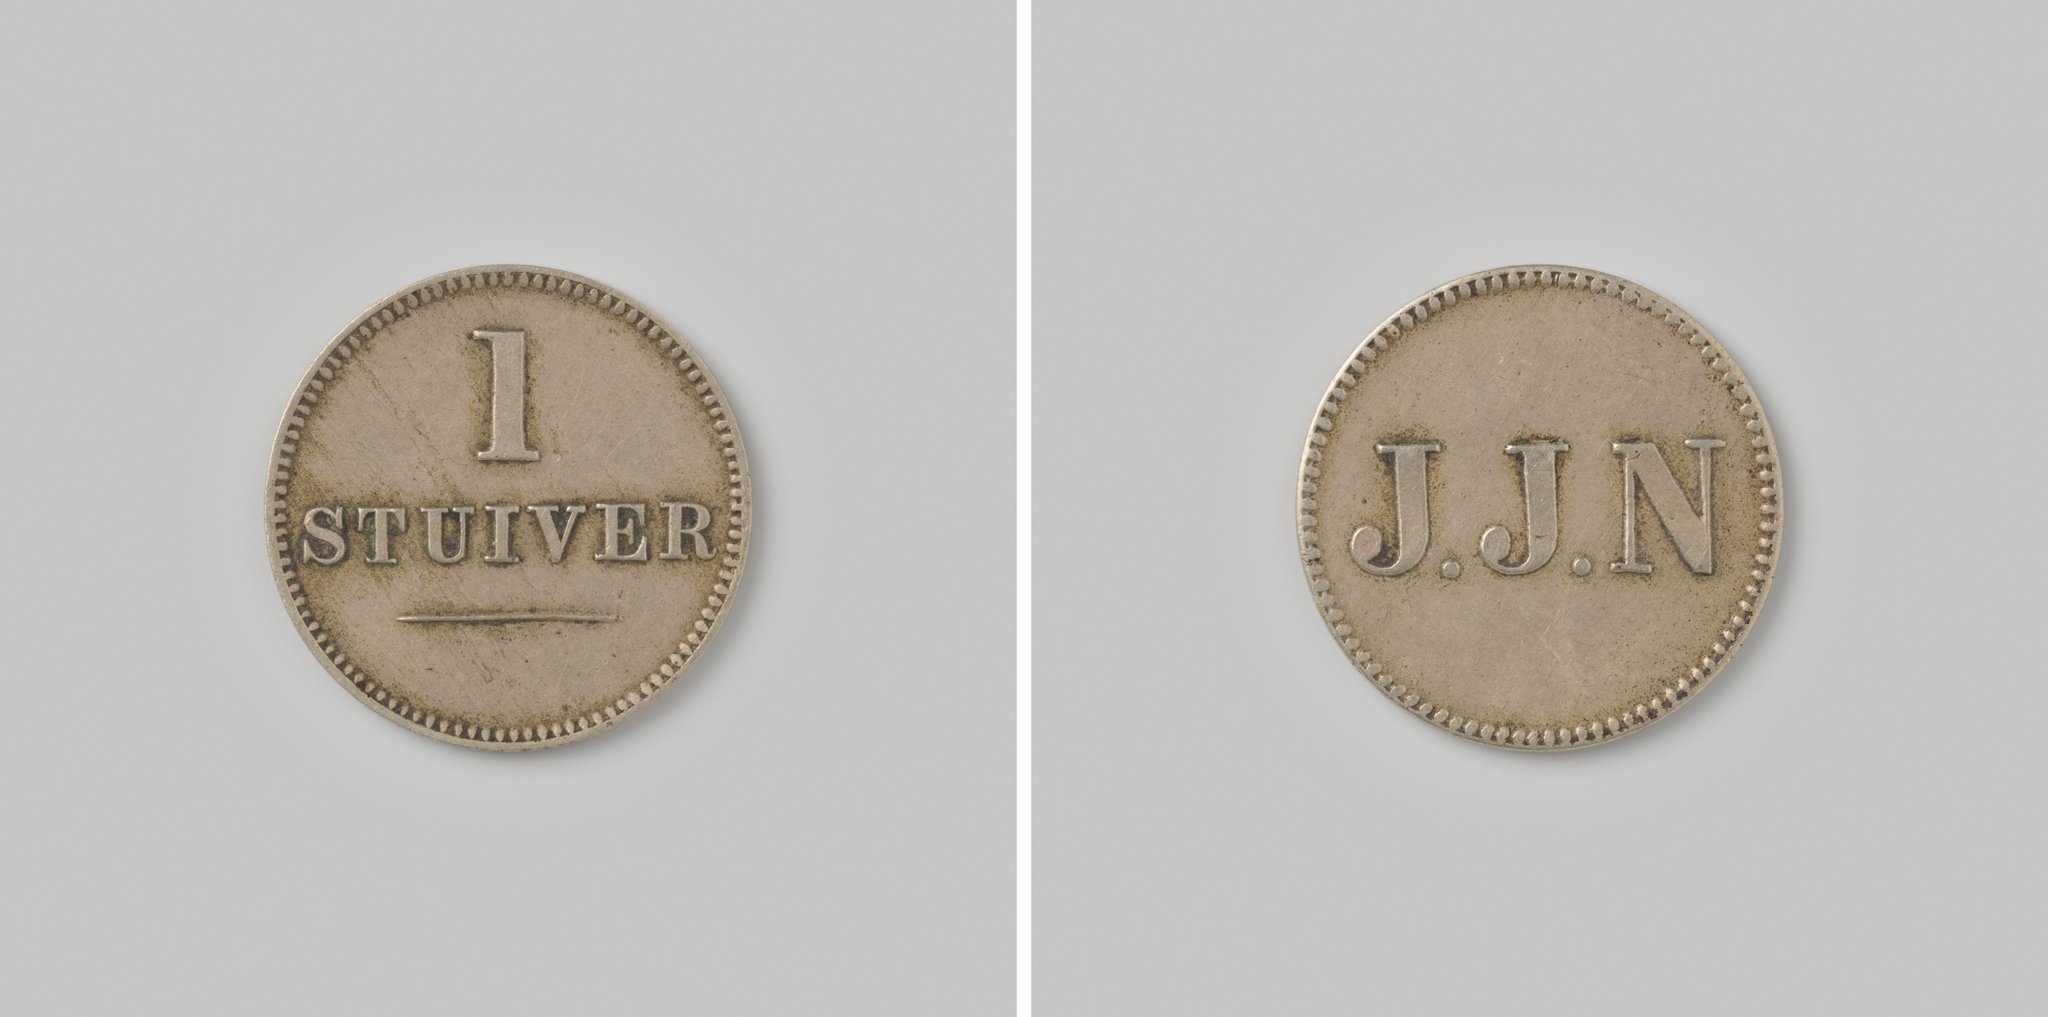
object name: coin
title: Particuliere stuiver van de firma J. J. Naär te Willemstad, Curacao, ca. 1880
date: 1875-1885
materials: nickel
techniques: striking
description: Nikkelen particuliere munt. Voorzijde: in twee regels waarde-aanduiding. Keerzijde: op eeen regel aanduiding van de particuliere firma J. J. Naär.